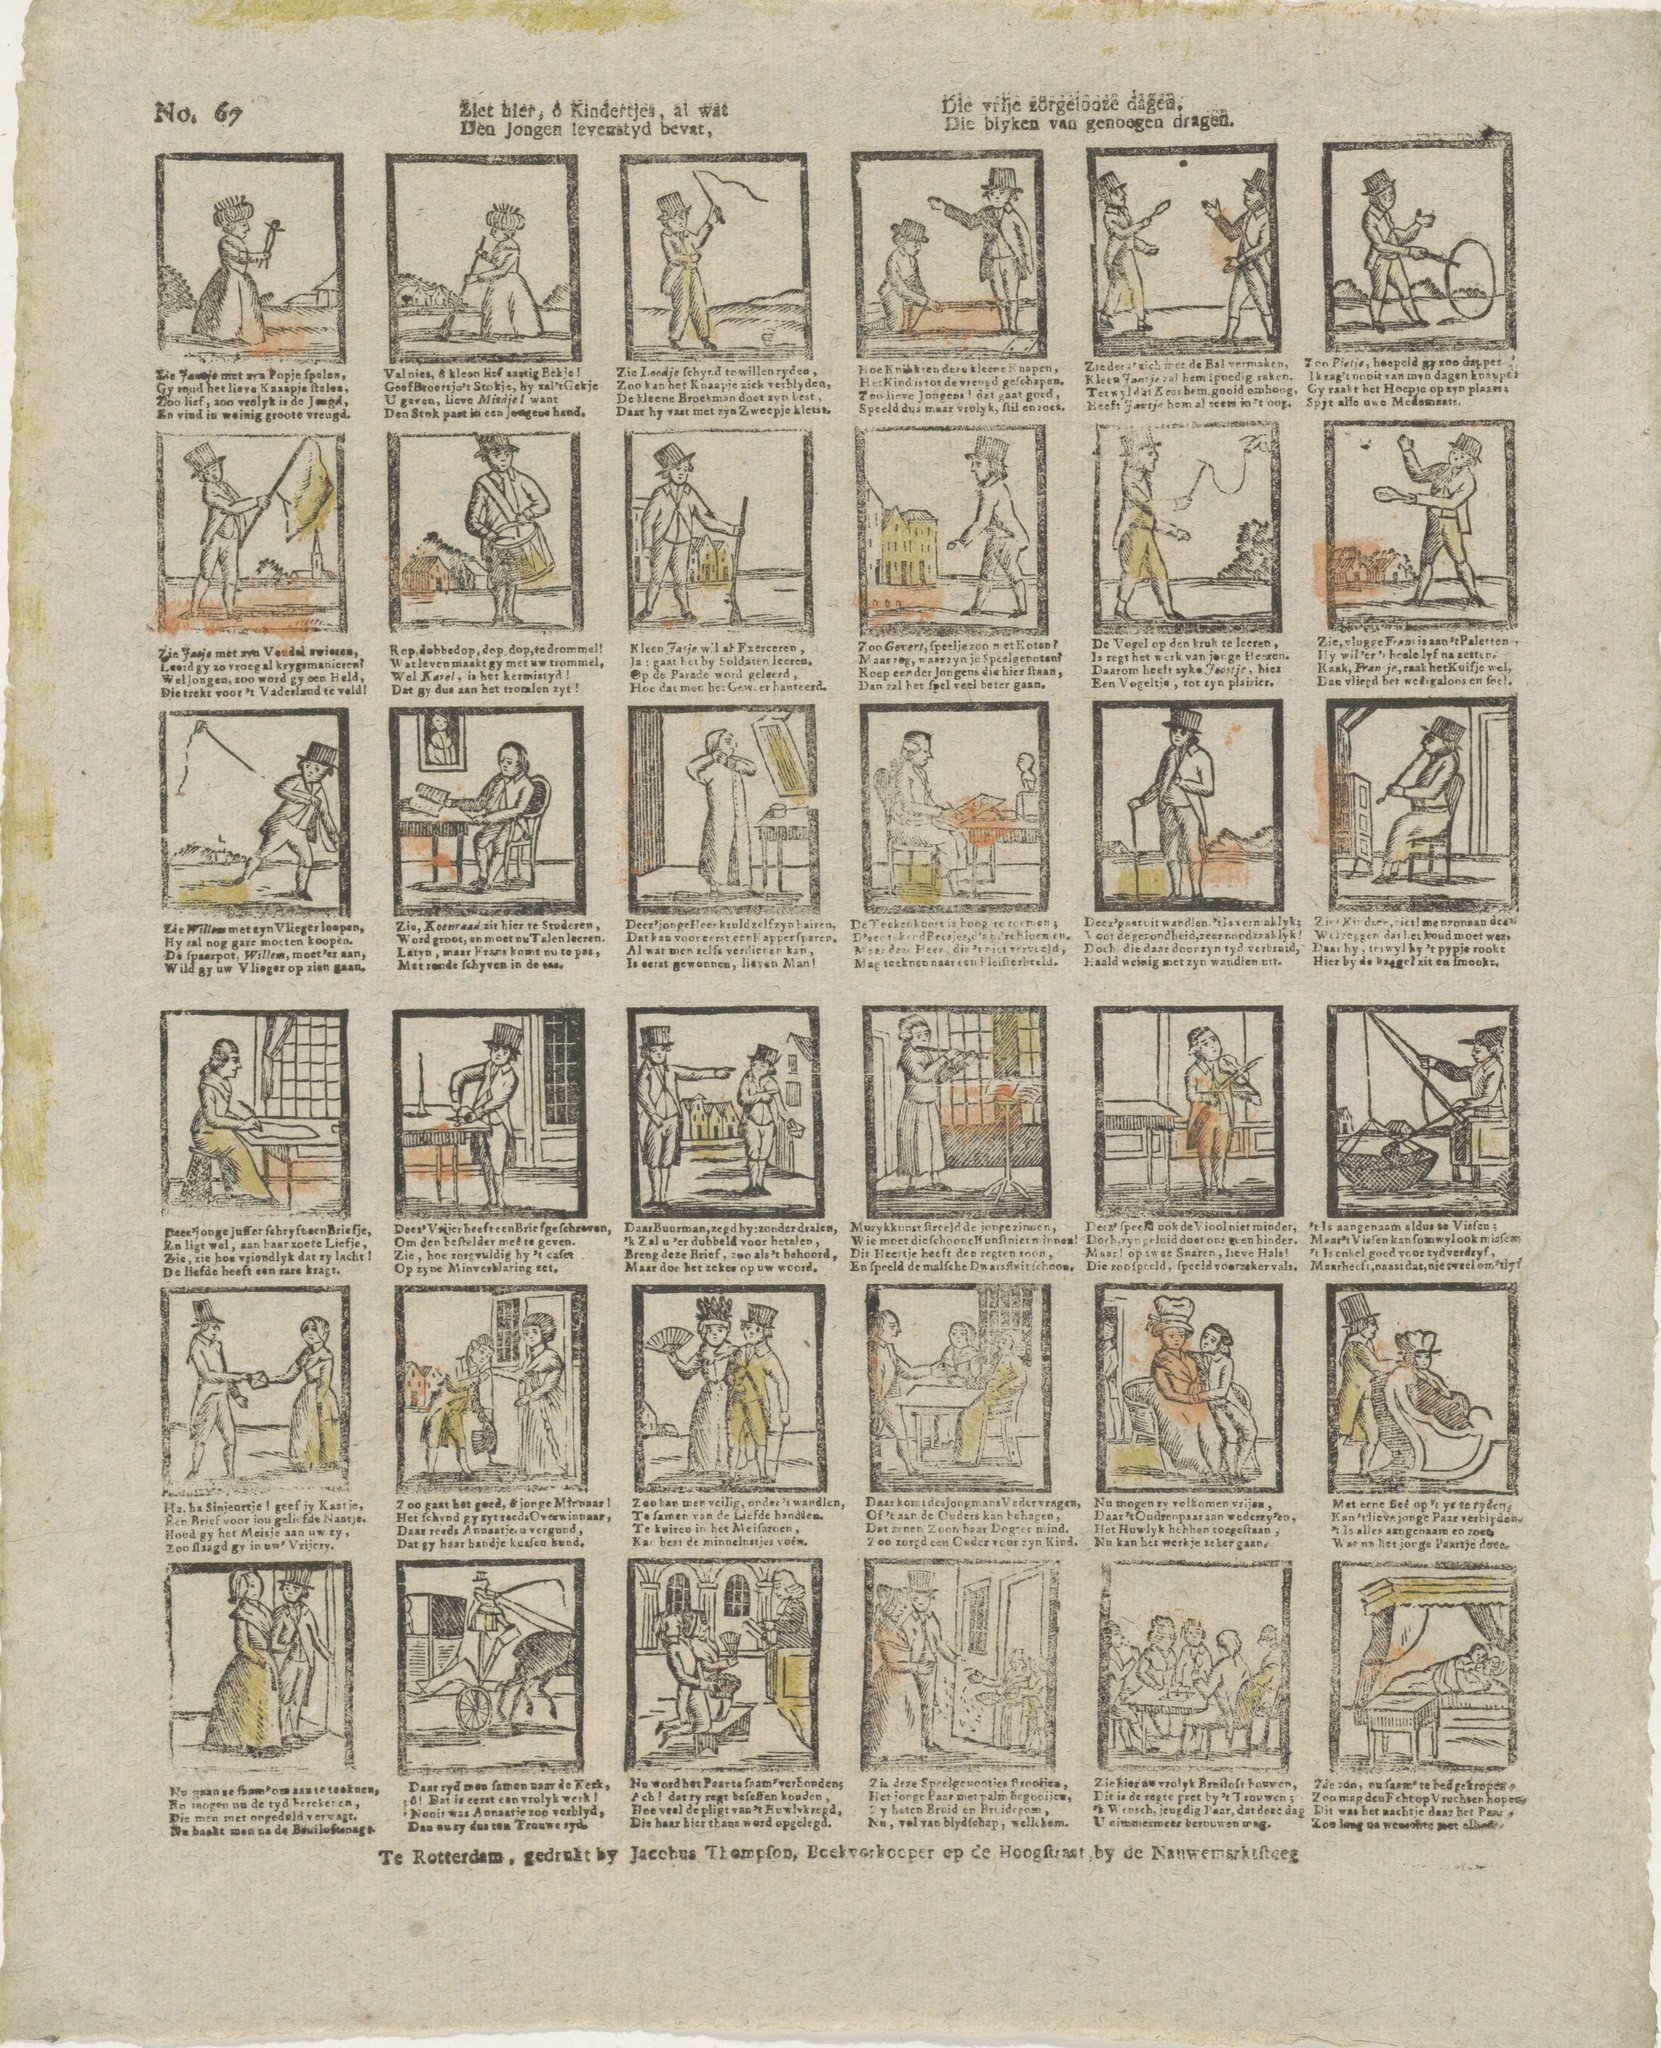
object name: popular print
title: Ziet hier, ô kindertjes, al wat / Demn jongen levenstyd bevat, / Die vrije zorgelooze dagen, / Die blyken van genoegen dragen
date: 1791-1812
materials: paper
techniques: colour, letterpress printing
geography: rotterdam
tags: wedding feast, wedding meal, the ages of man, infant, baby ~ the ages of man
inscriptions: collector's mark: Lugt 2760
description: Blad met 36 voorstellingen van verschillende fasen uit het leven van de mens, van geboorte tot trouwen. Onder elke afbeelding een vierregelig vers. Genummerd linksboven: No. 67.